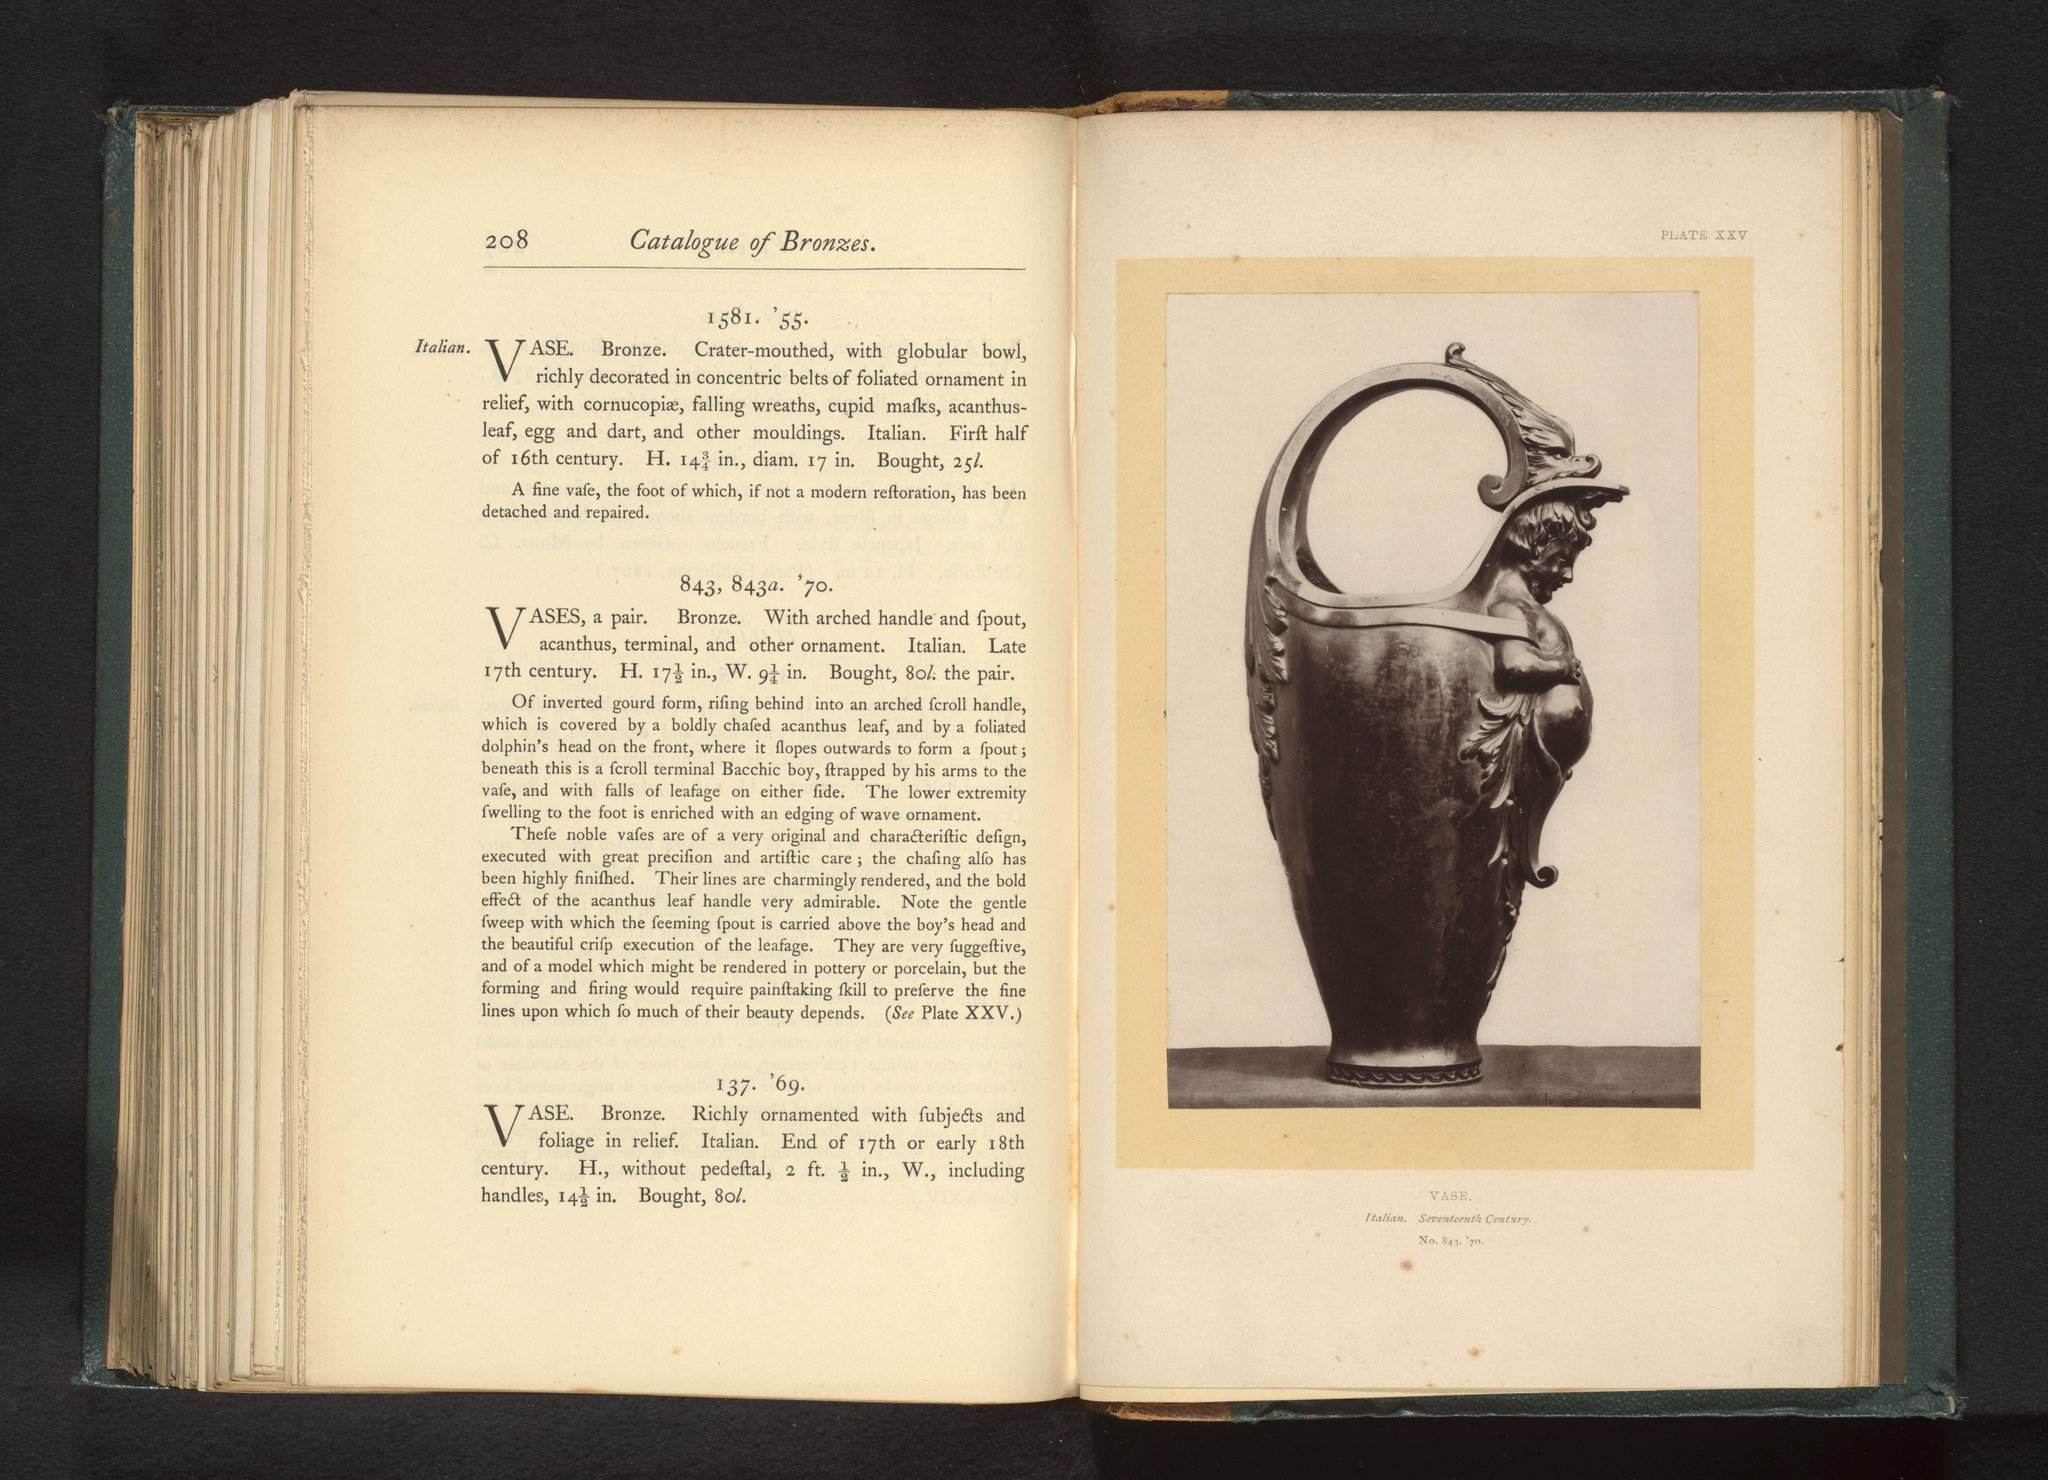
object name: photomechanical print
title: Vase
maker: Anonymous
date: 1869-1876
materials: paper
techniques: woodburytype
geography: london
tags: container of metal: bucket, can, canister, drum, tin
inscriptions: number: ‘Plate XXV.’, inscription: ‘Italian. Seventeenth Century.’, number: ‘No. 843. '70.’